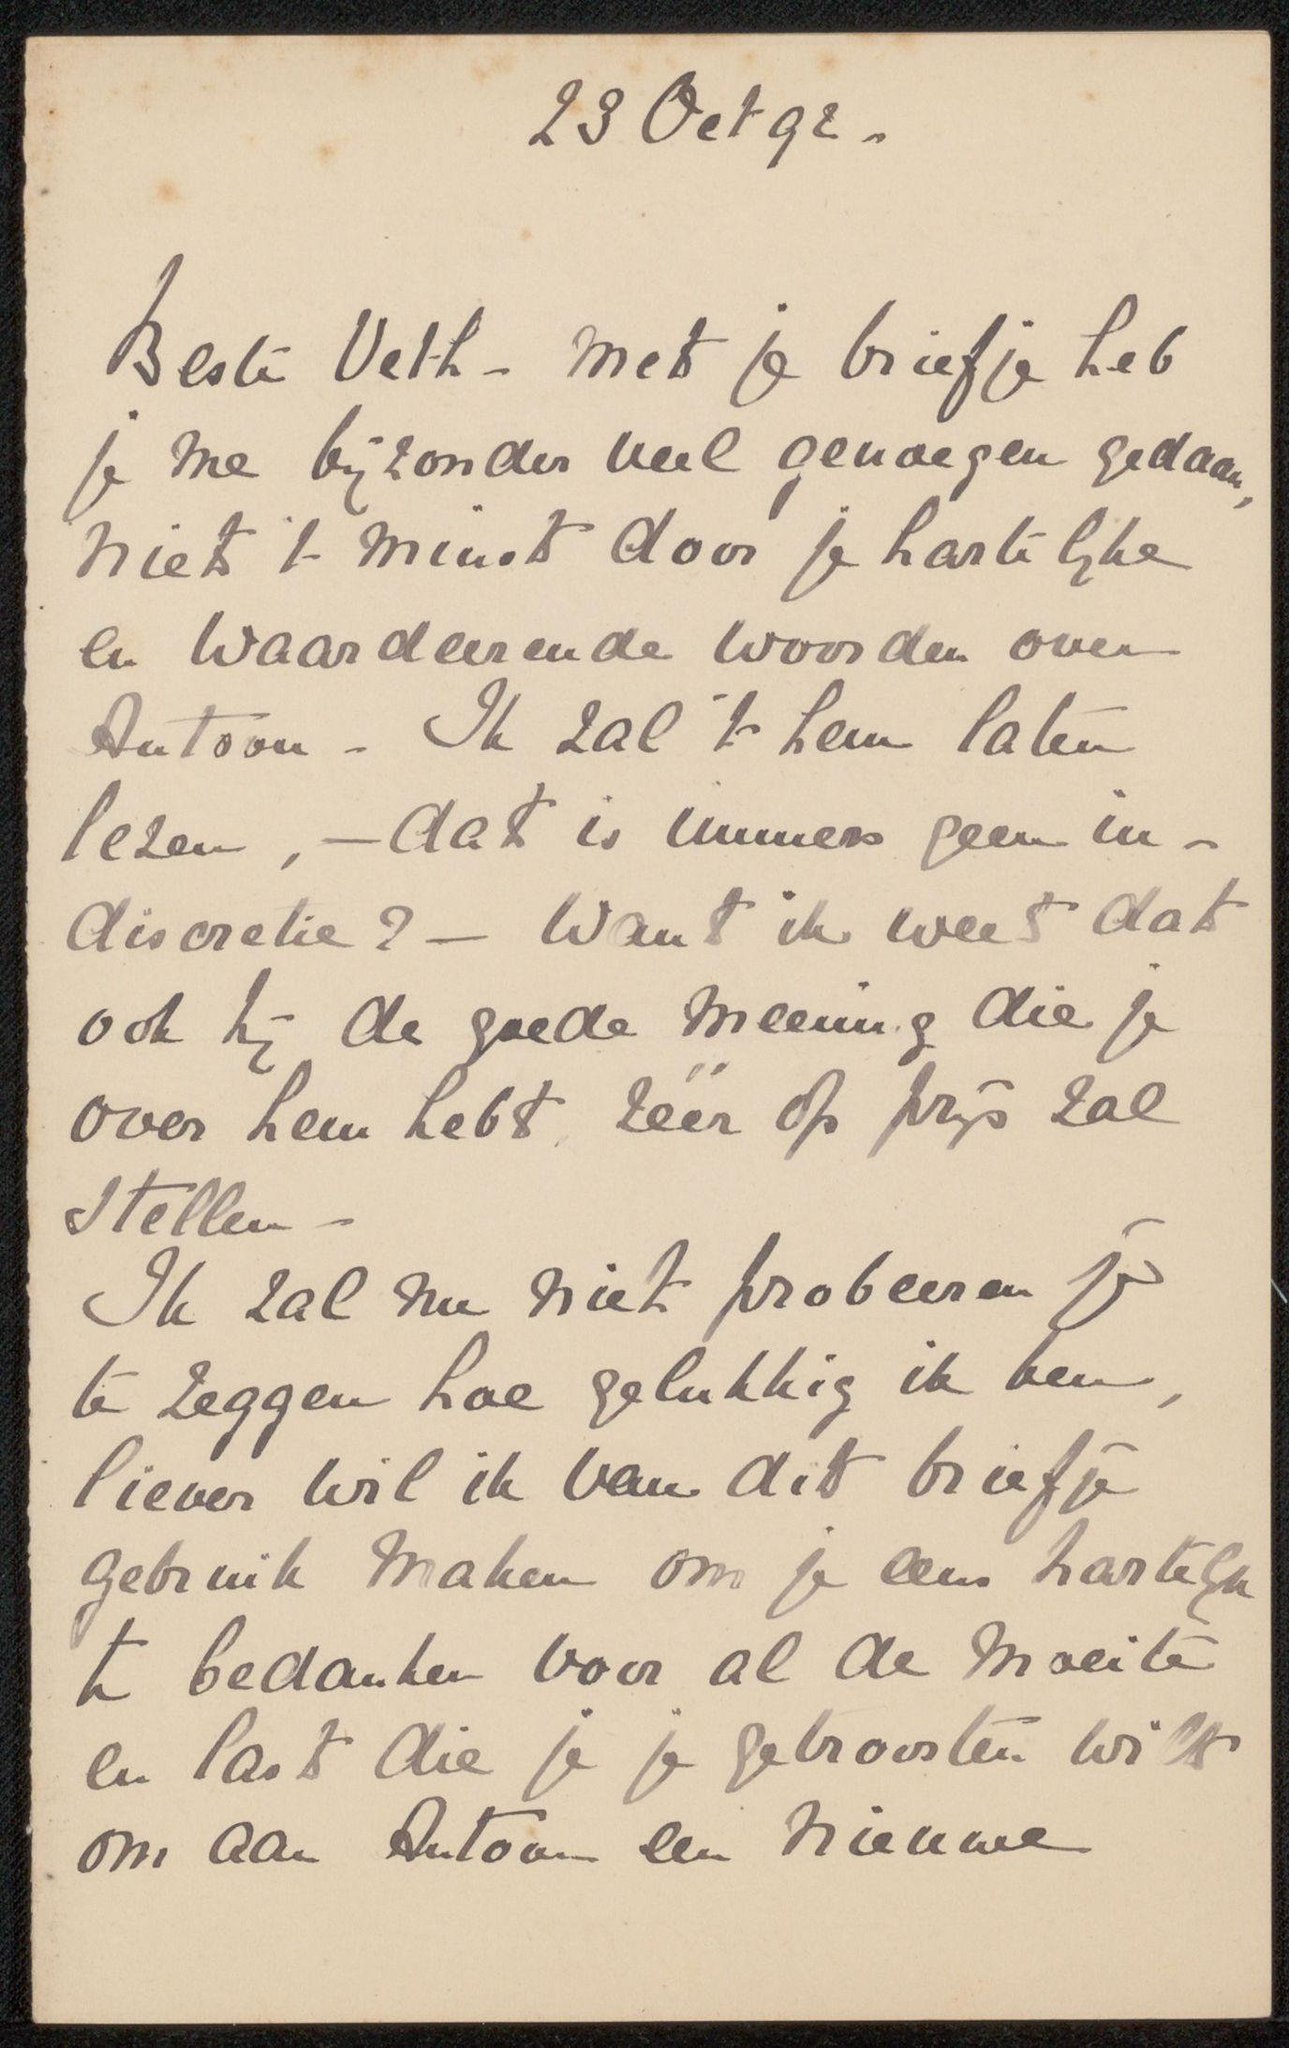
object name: letter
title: Brief aan Jan Veth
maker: johanna henriëtte besier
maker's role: print maker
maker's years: 1865-1944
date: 1892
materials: ink, paper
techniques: pen, writing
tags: dordrecht, jan veth, den bosch, amsterdam, painter, print maker, draughtsman, antoon derkinderen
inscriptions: collector's mark: ‘RPK’